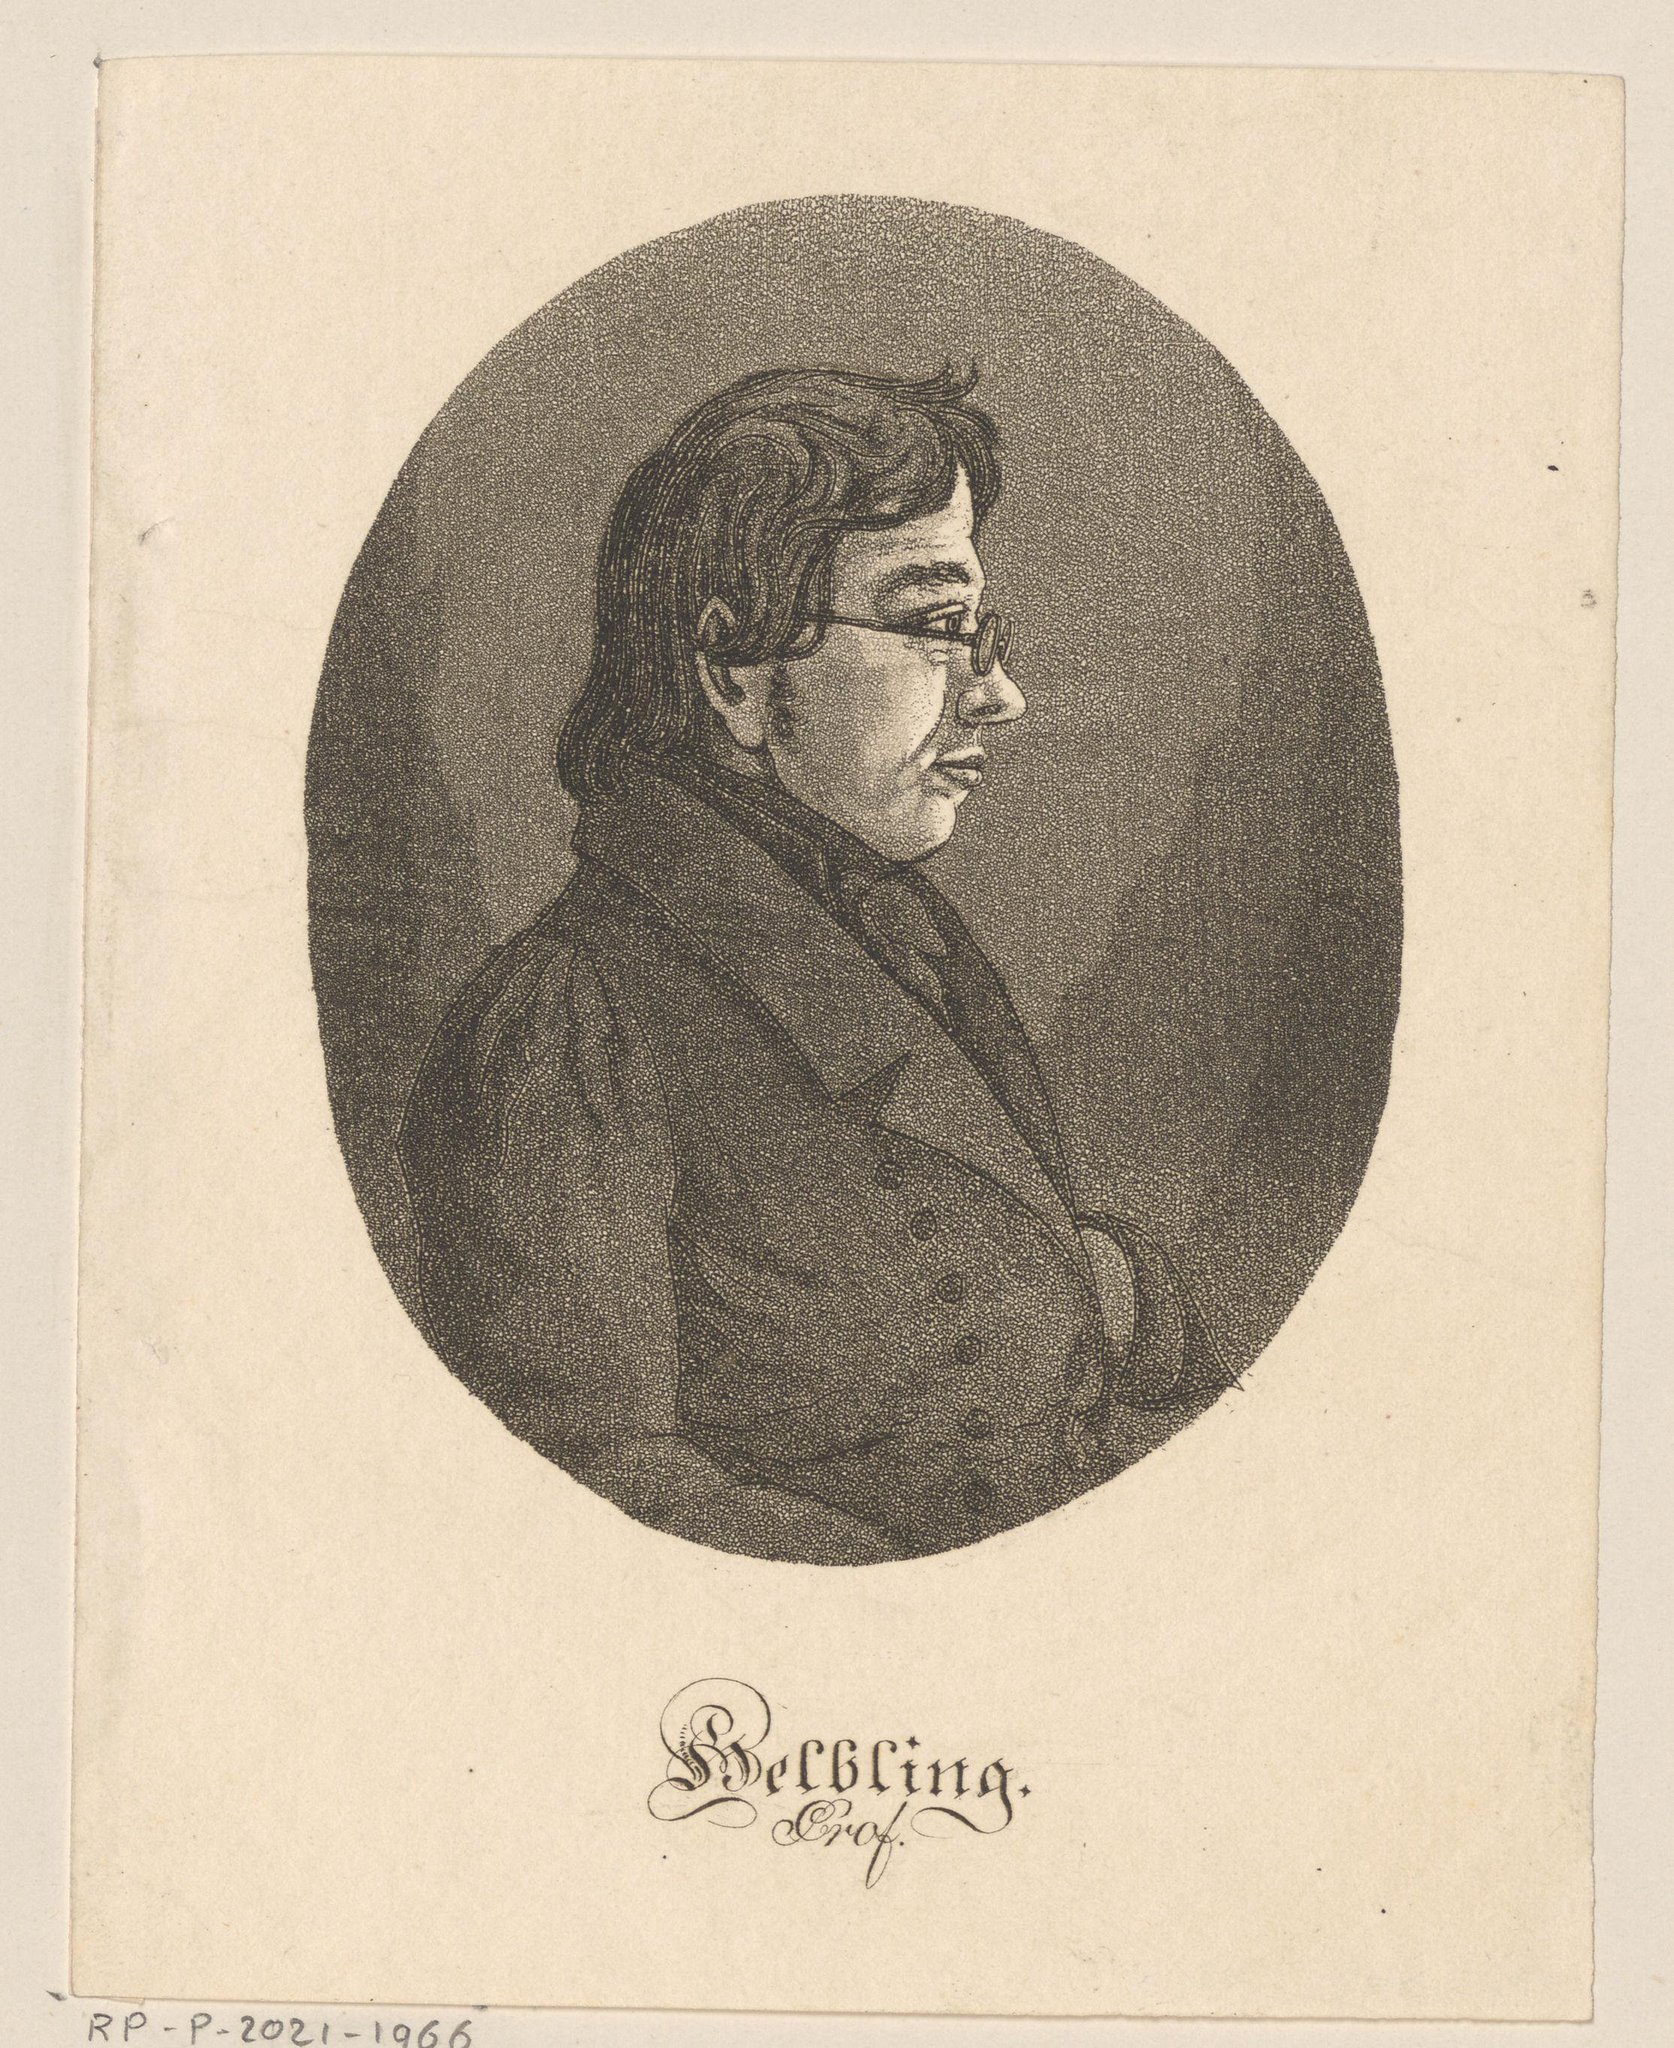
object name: print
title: Portret van professor Helbling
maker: Anonymous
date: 1800-1899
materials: paper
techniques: aquatint, engraving, etching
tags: historical persons, professor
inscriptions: collector's mark: Lugt 2233